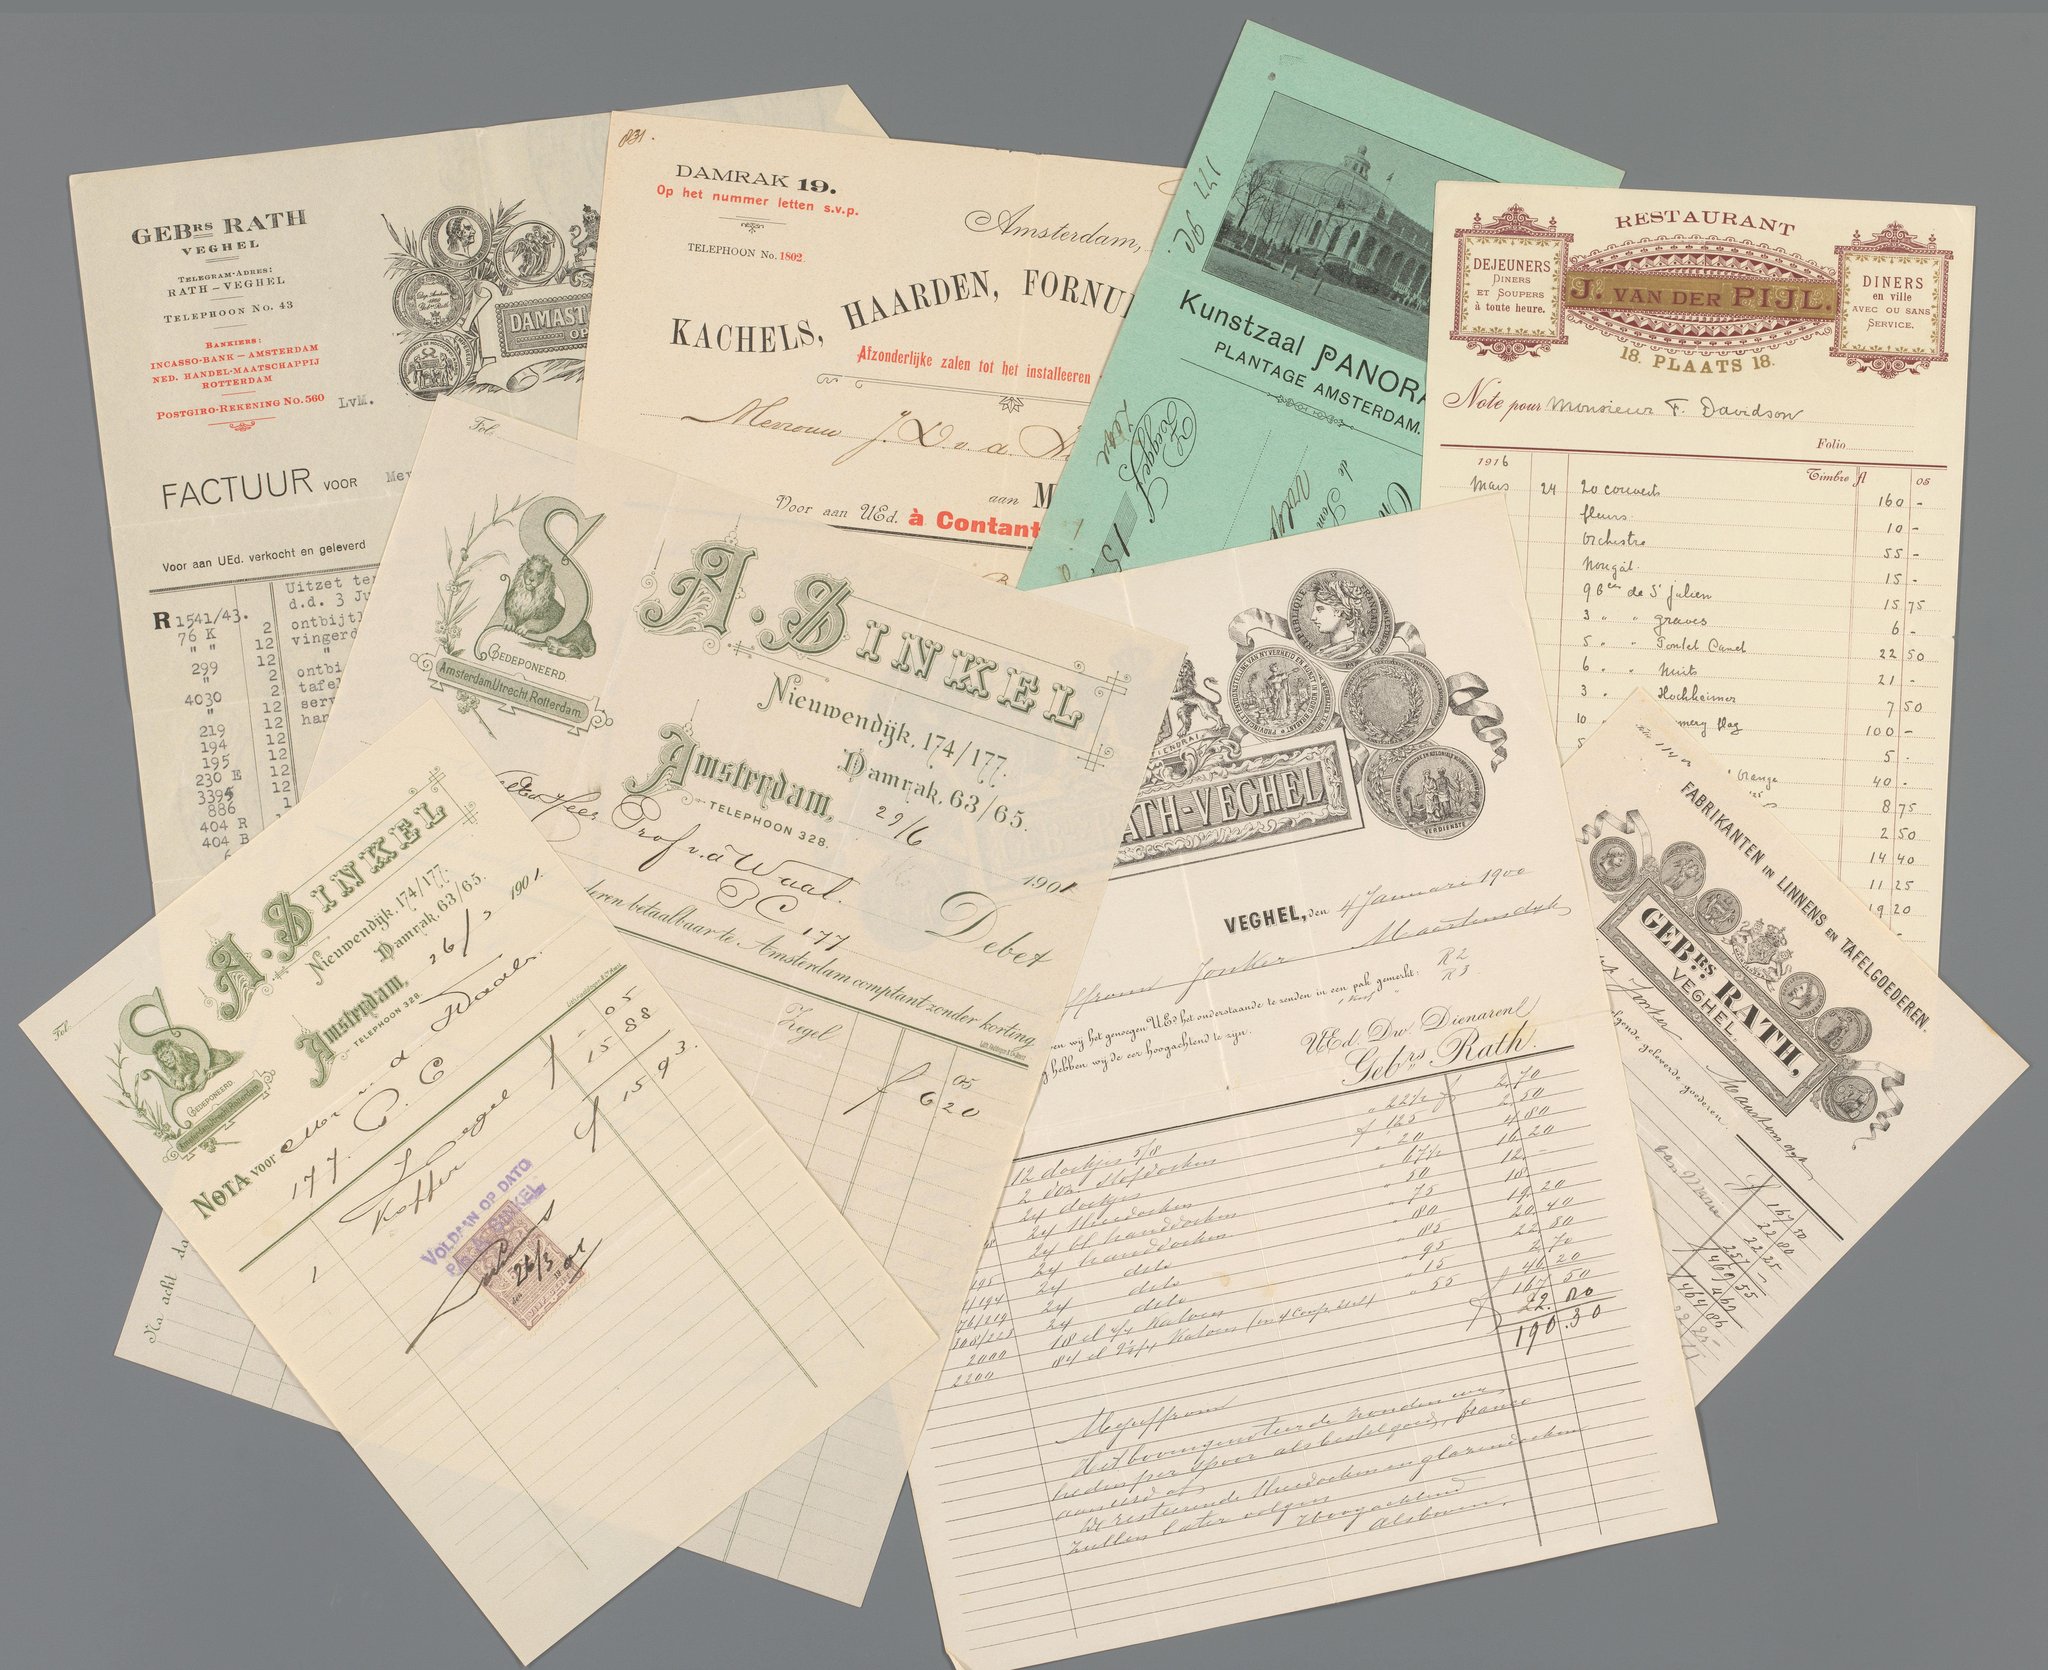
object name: print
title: 86 rekeningen en kwitanties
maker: Anonymous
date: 1900-1936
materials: ink, paper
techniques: handwriting, lithograph, offset printed, pen, engraving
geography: netherlands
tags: cheque, draft, bill of exchange, trade mark, trade token, trade sign, trade card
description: Groep van 87 rekeningen en kwitanties. Bladen met voorgedrukte namen en emblemen van winkels, bedrijven en gelegenheden, beschreven met handschrift pen in inkt of typeschrift, vaak met onderaan een frankeerzegel. Uit de periode ca. 1900-1936. Van o.a.: de Winkel van Sinkel op de Nieuwendijk te Amsterdam en De Kunstzaal Panorama in de Plantage Amsterdam. Voor een groot deel van de bladen beschreven op de verso als notitieblad voor informatie over terminologie van kledingstukken. Veel van de documenten staan op de naam van prof. G. Kalff en mej. E.J. Kalff te Leiden.